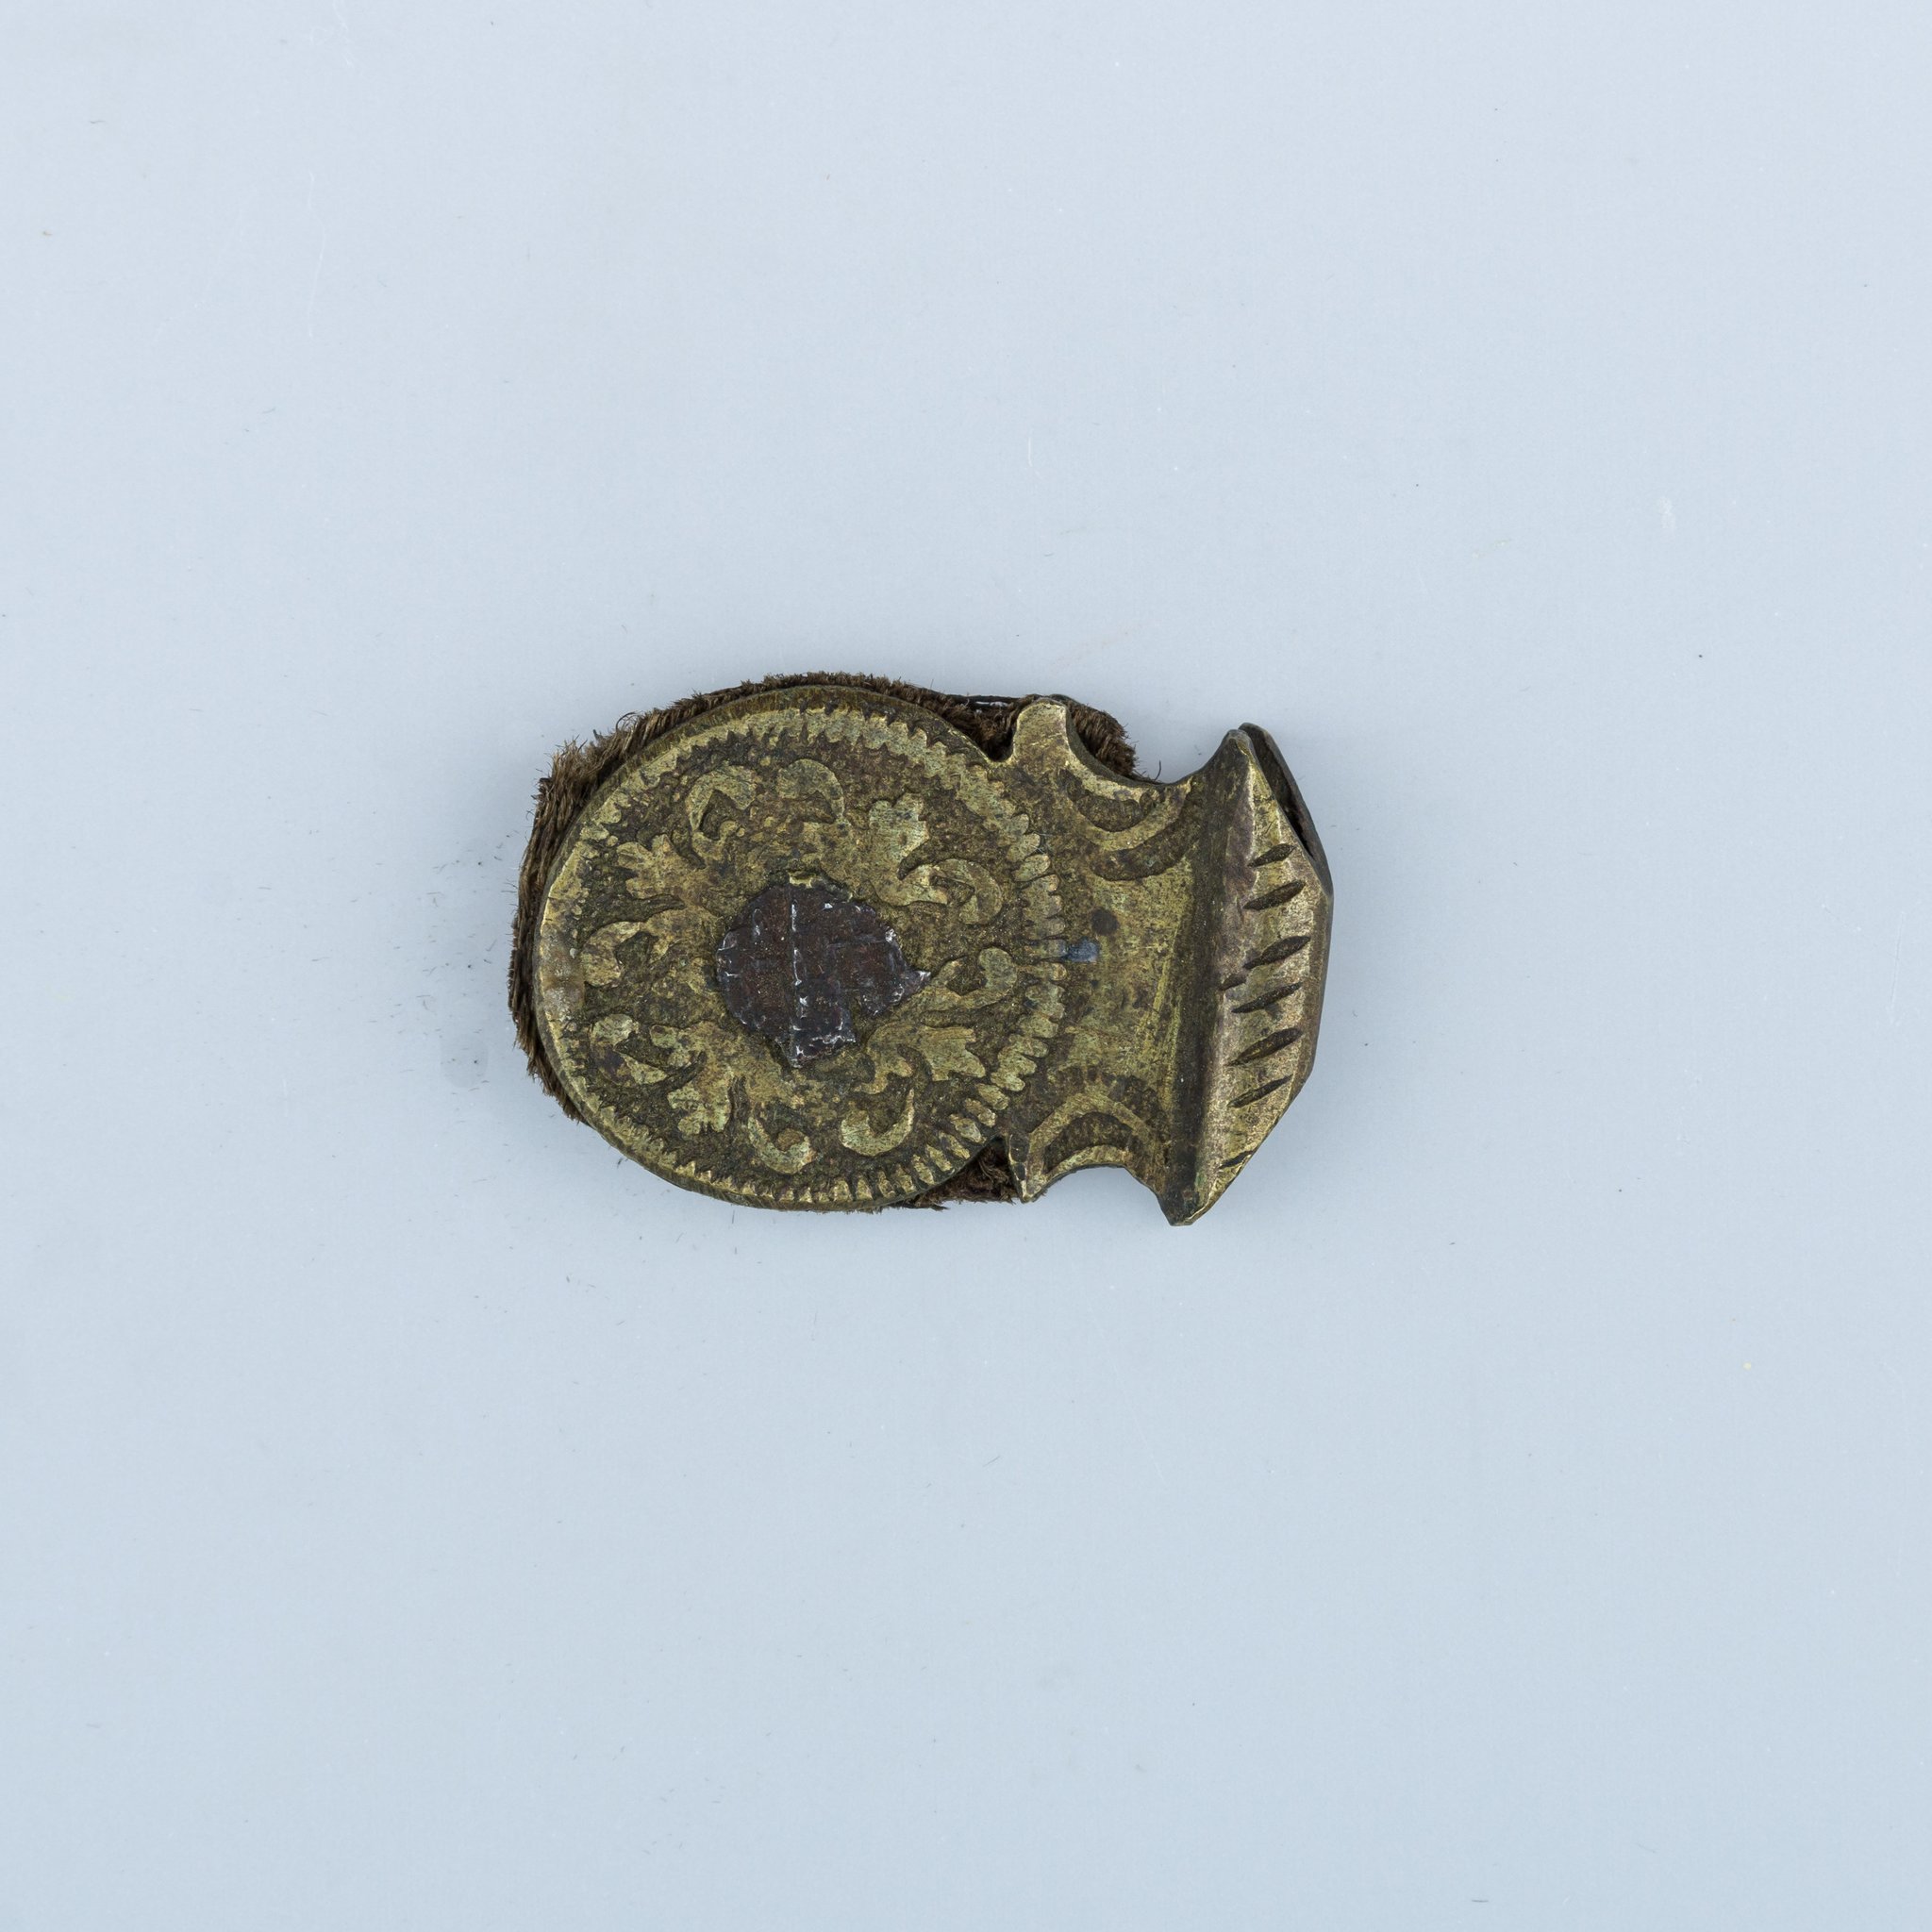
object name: mordant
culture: german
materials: brass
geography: germany